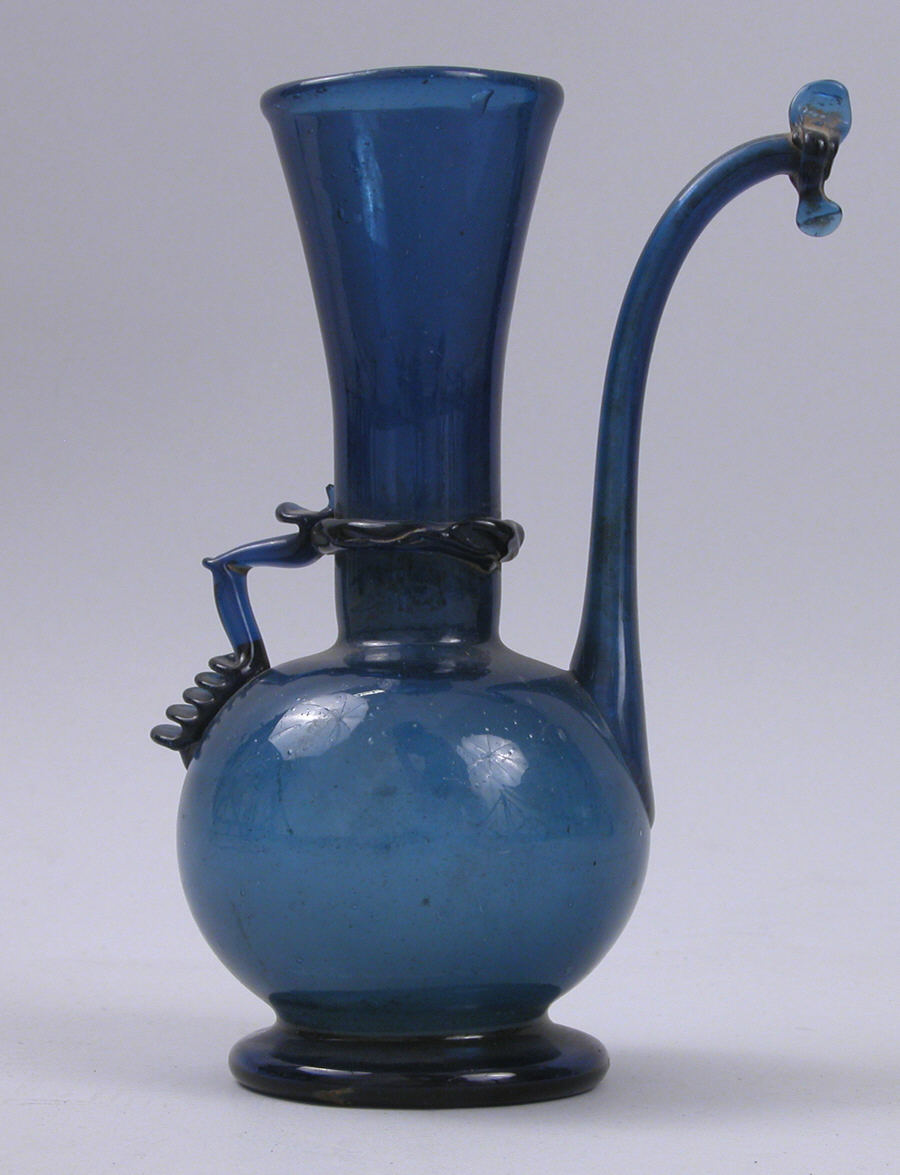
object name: ewer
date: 1701-1900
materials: glass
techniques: glassblowing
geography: iran